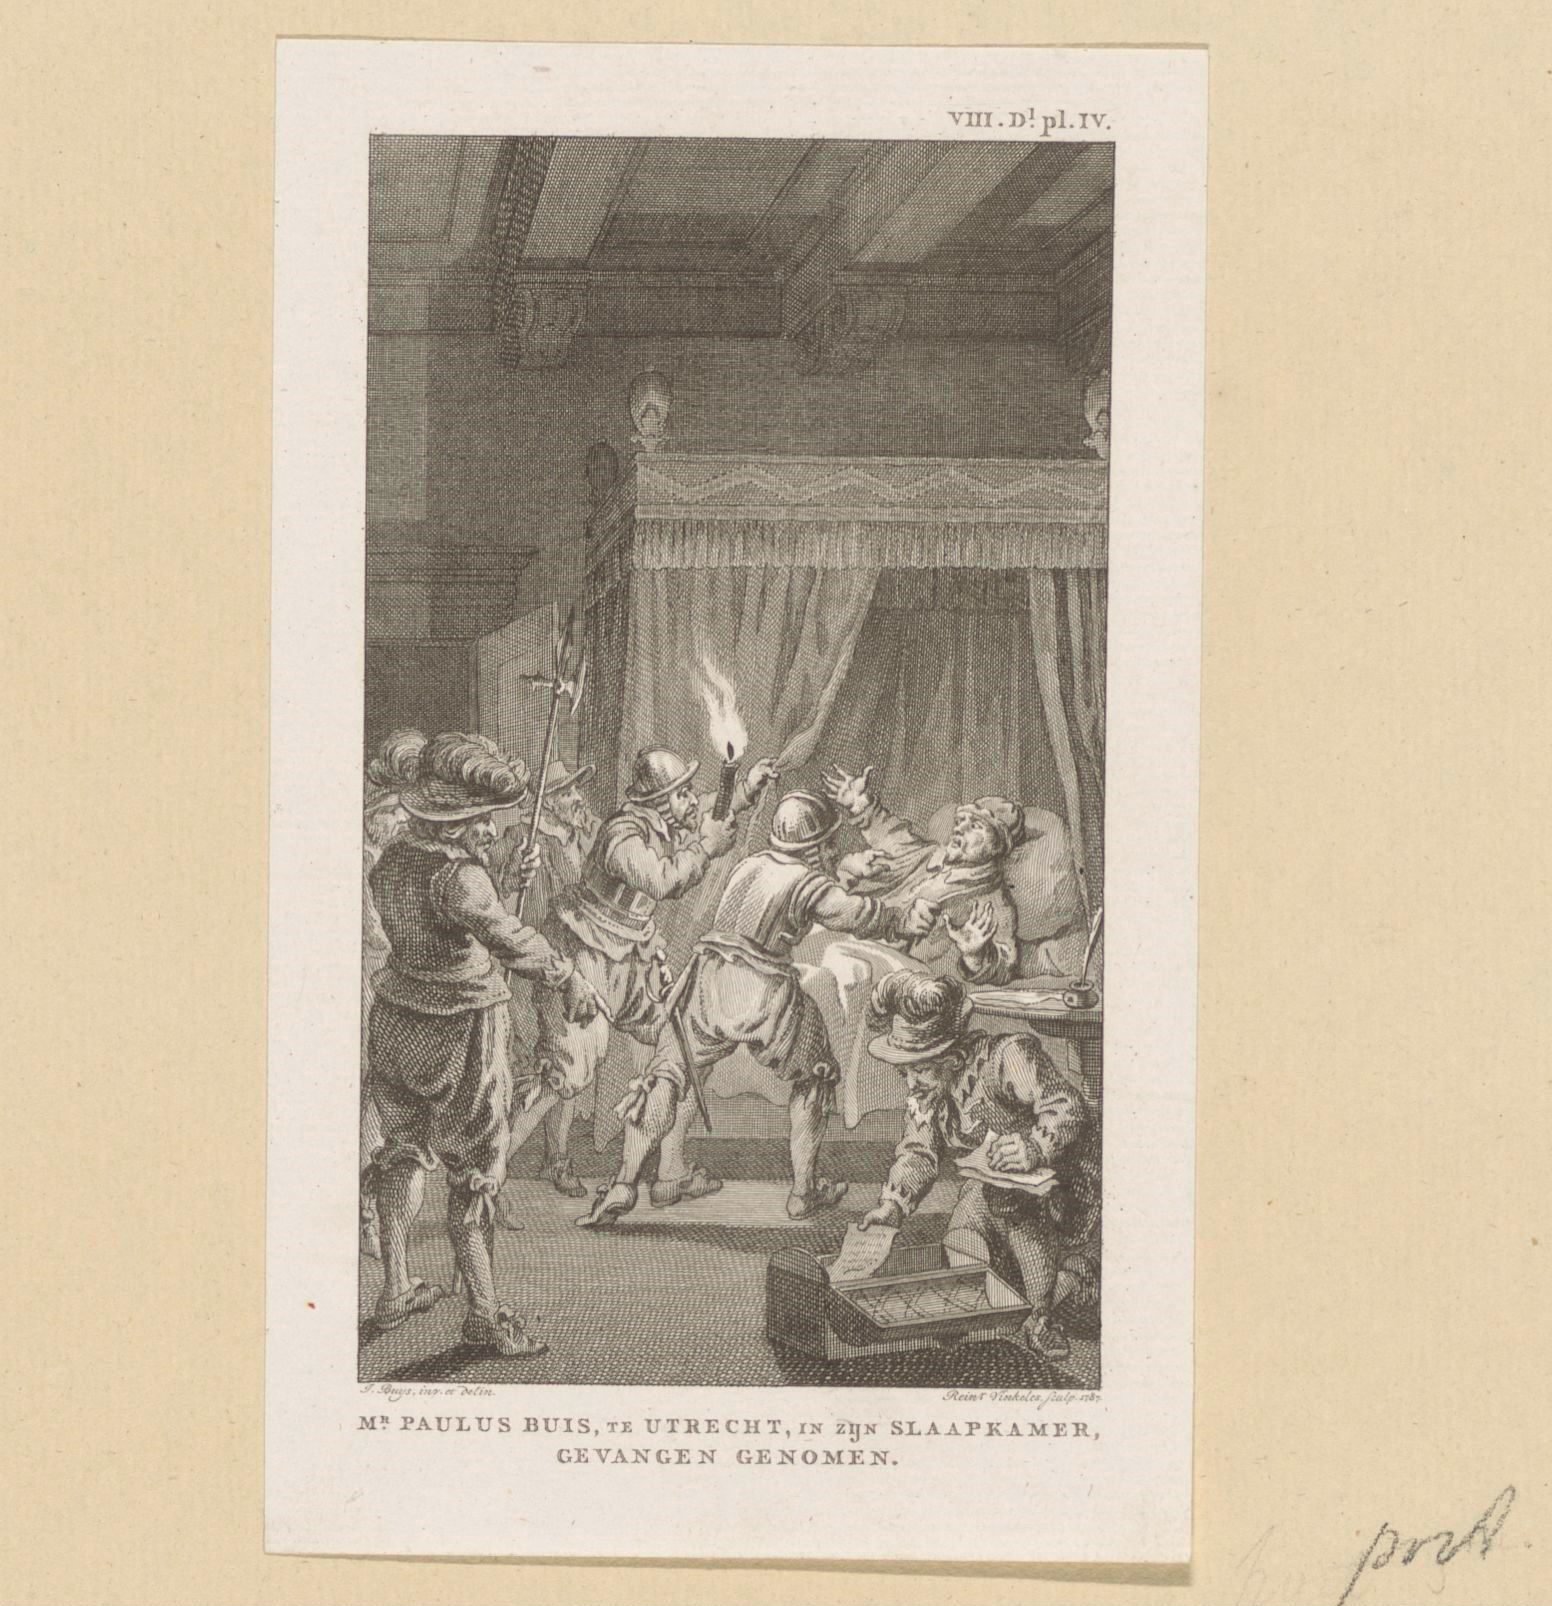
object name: history print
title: Mr. Paulus Buis, te Utrecht, in zijn slaapkamer, gevangen genomen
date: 1787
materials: paper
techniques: engraving, etching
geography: amsterdam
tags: robert dudley (1st earl of leicester), bed, arrest (of criminal), utrecht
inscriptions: date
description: Paulus Buis, pensionaris van Utrecht, 's nachts op bevel van de graaf van Leicester in zijn slaapkamer gevangengenomen, 19 juli 1586.